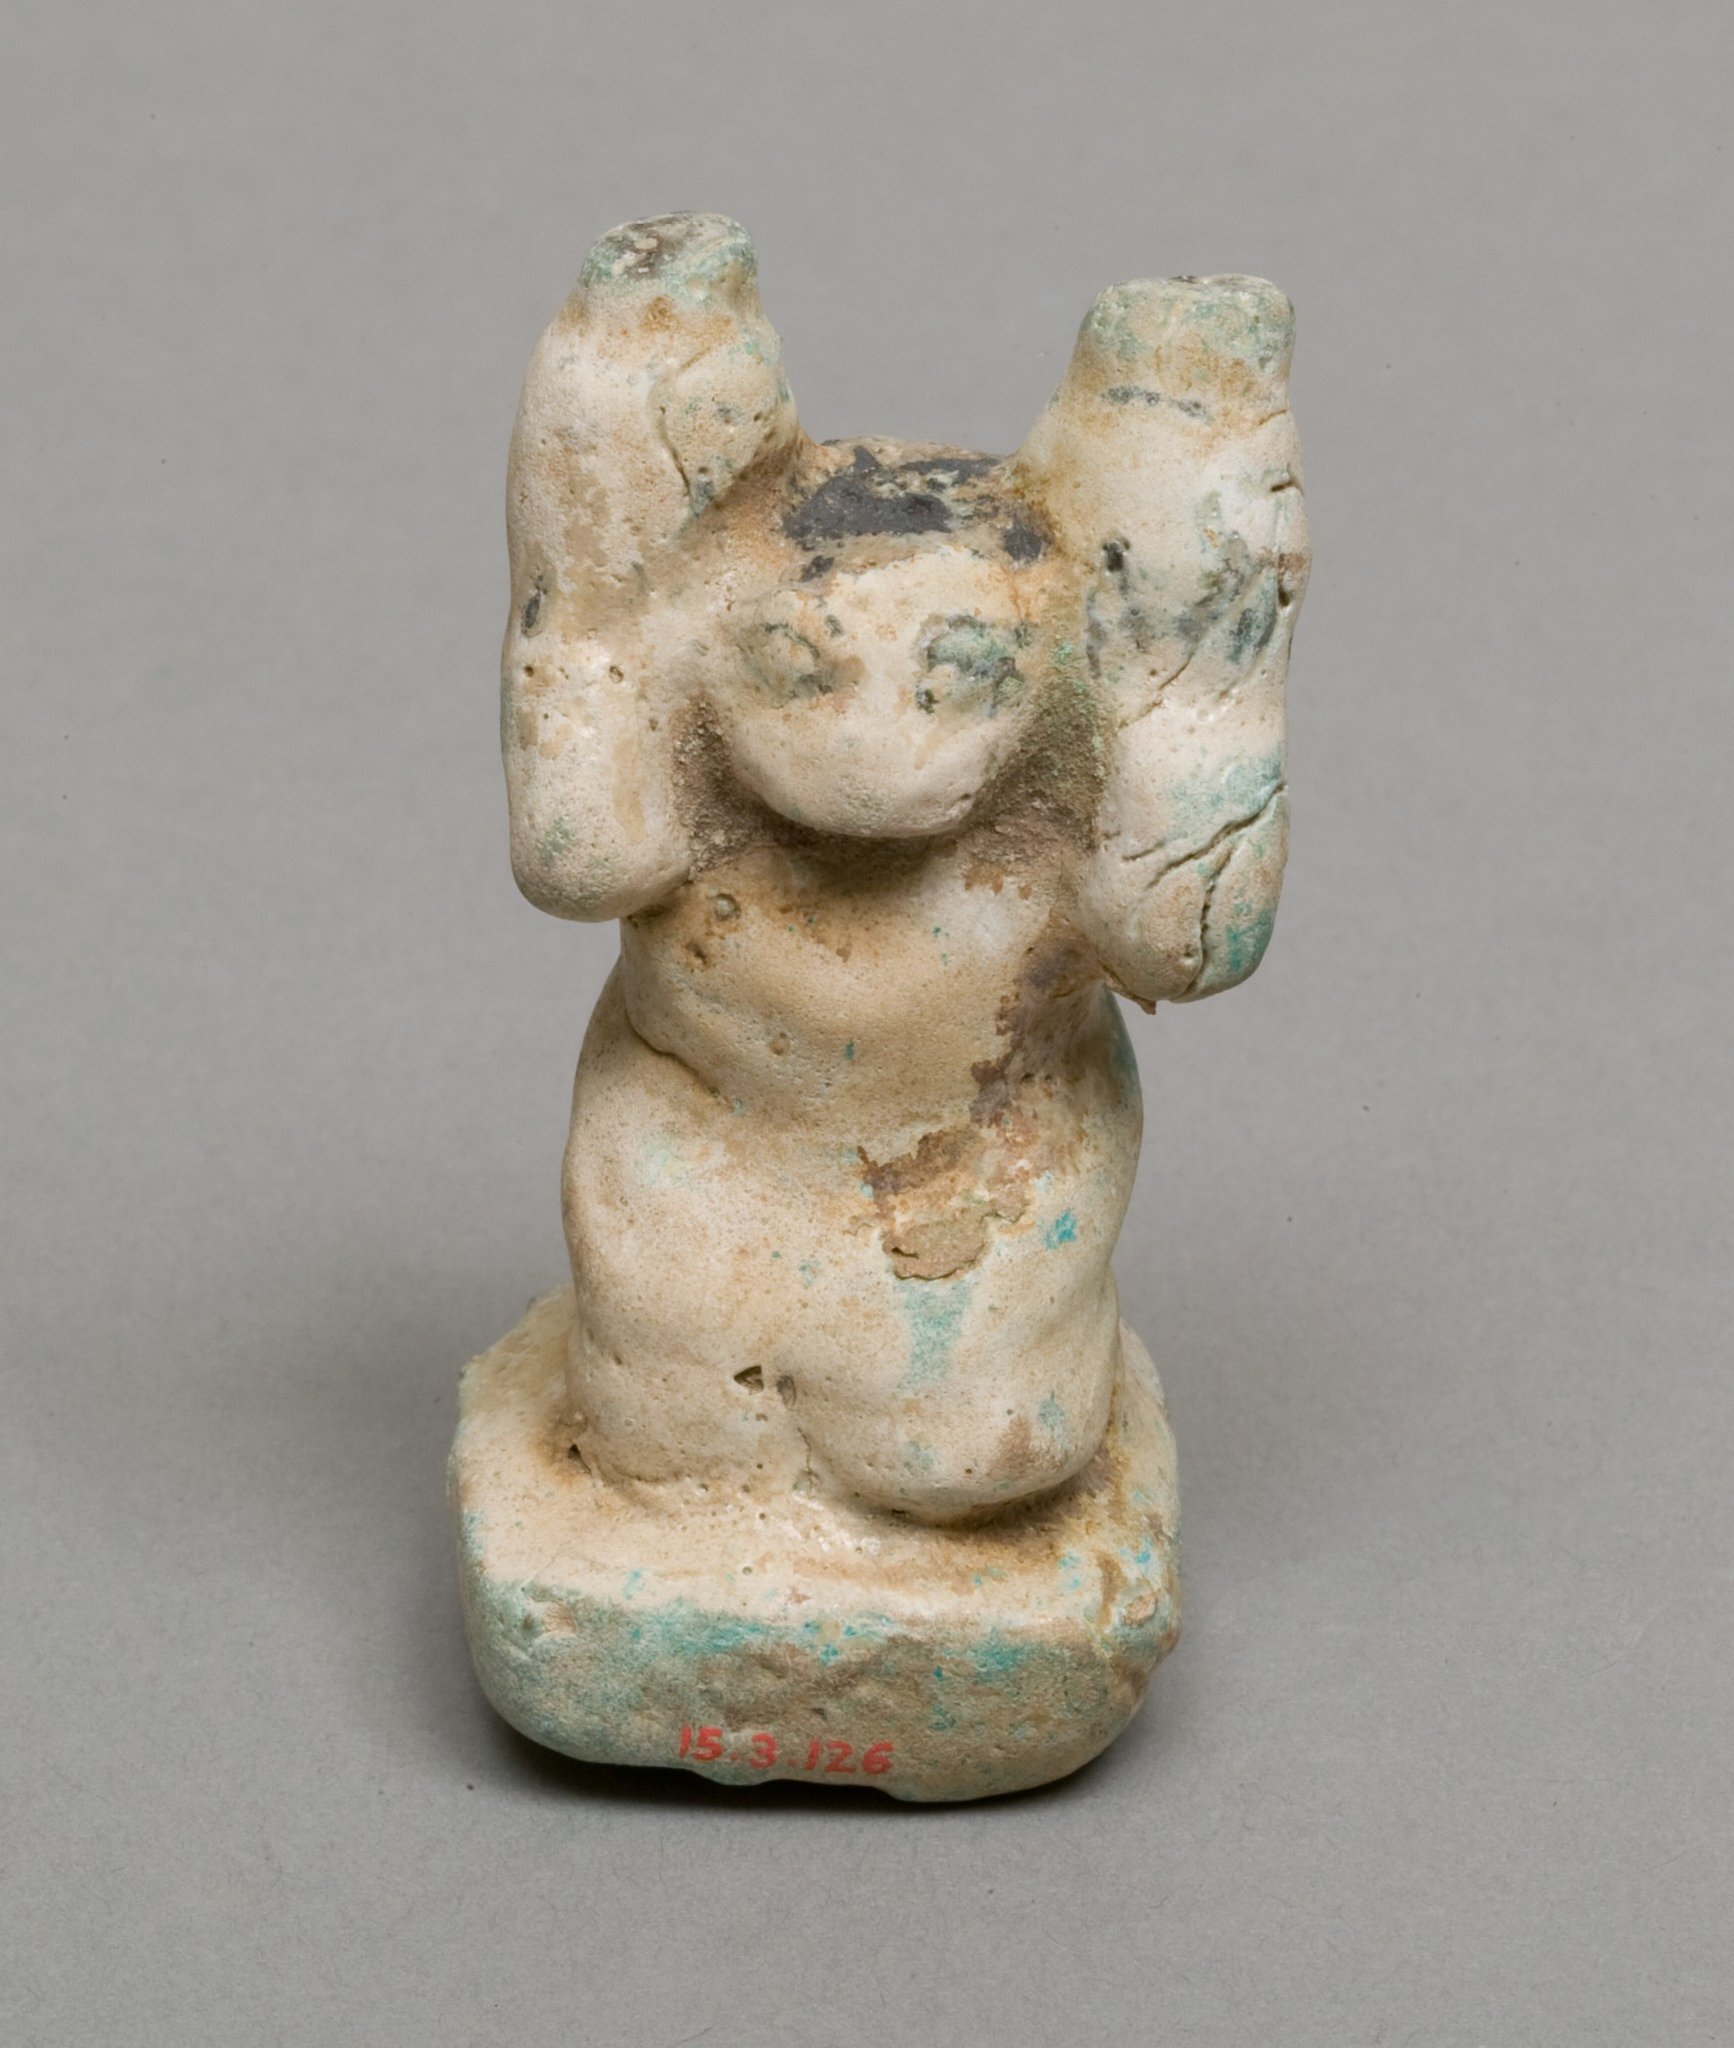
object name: statuette, servant carrying jar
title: Figure of Servant carrying jars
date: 1850-1700 BCE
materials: faience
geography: egypt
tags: human figures,servants